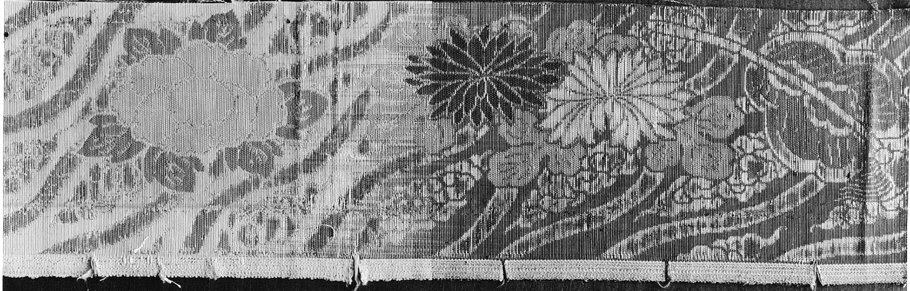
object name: fragment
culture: japanese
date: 1701-1800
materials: metal thread, silk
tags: flowers